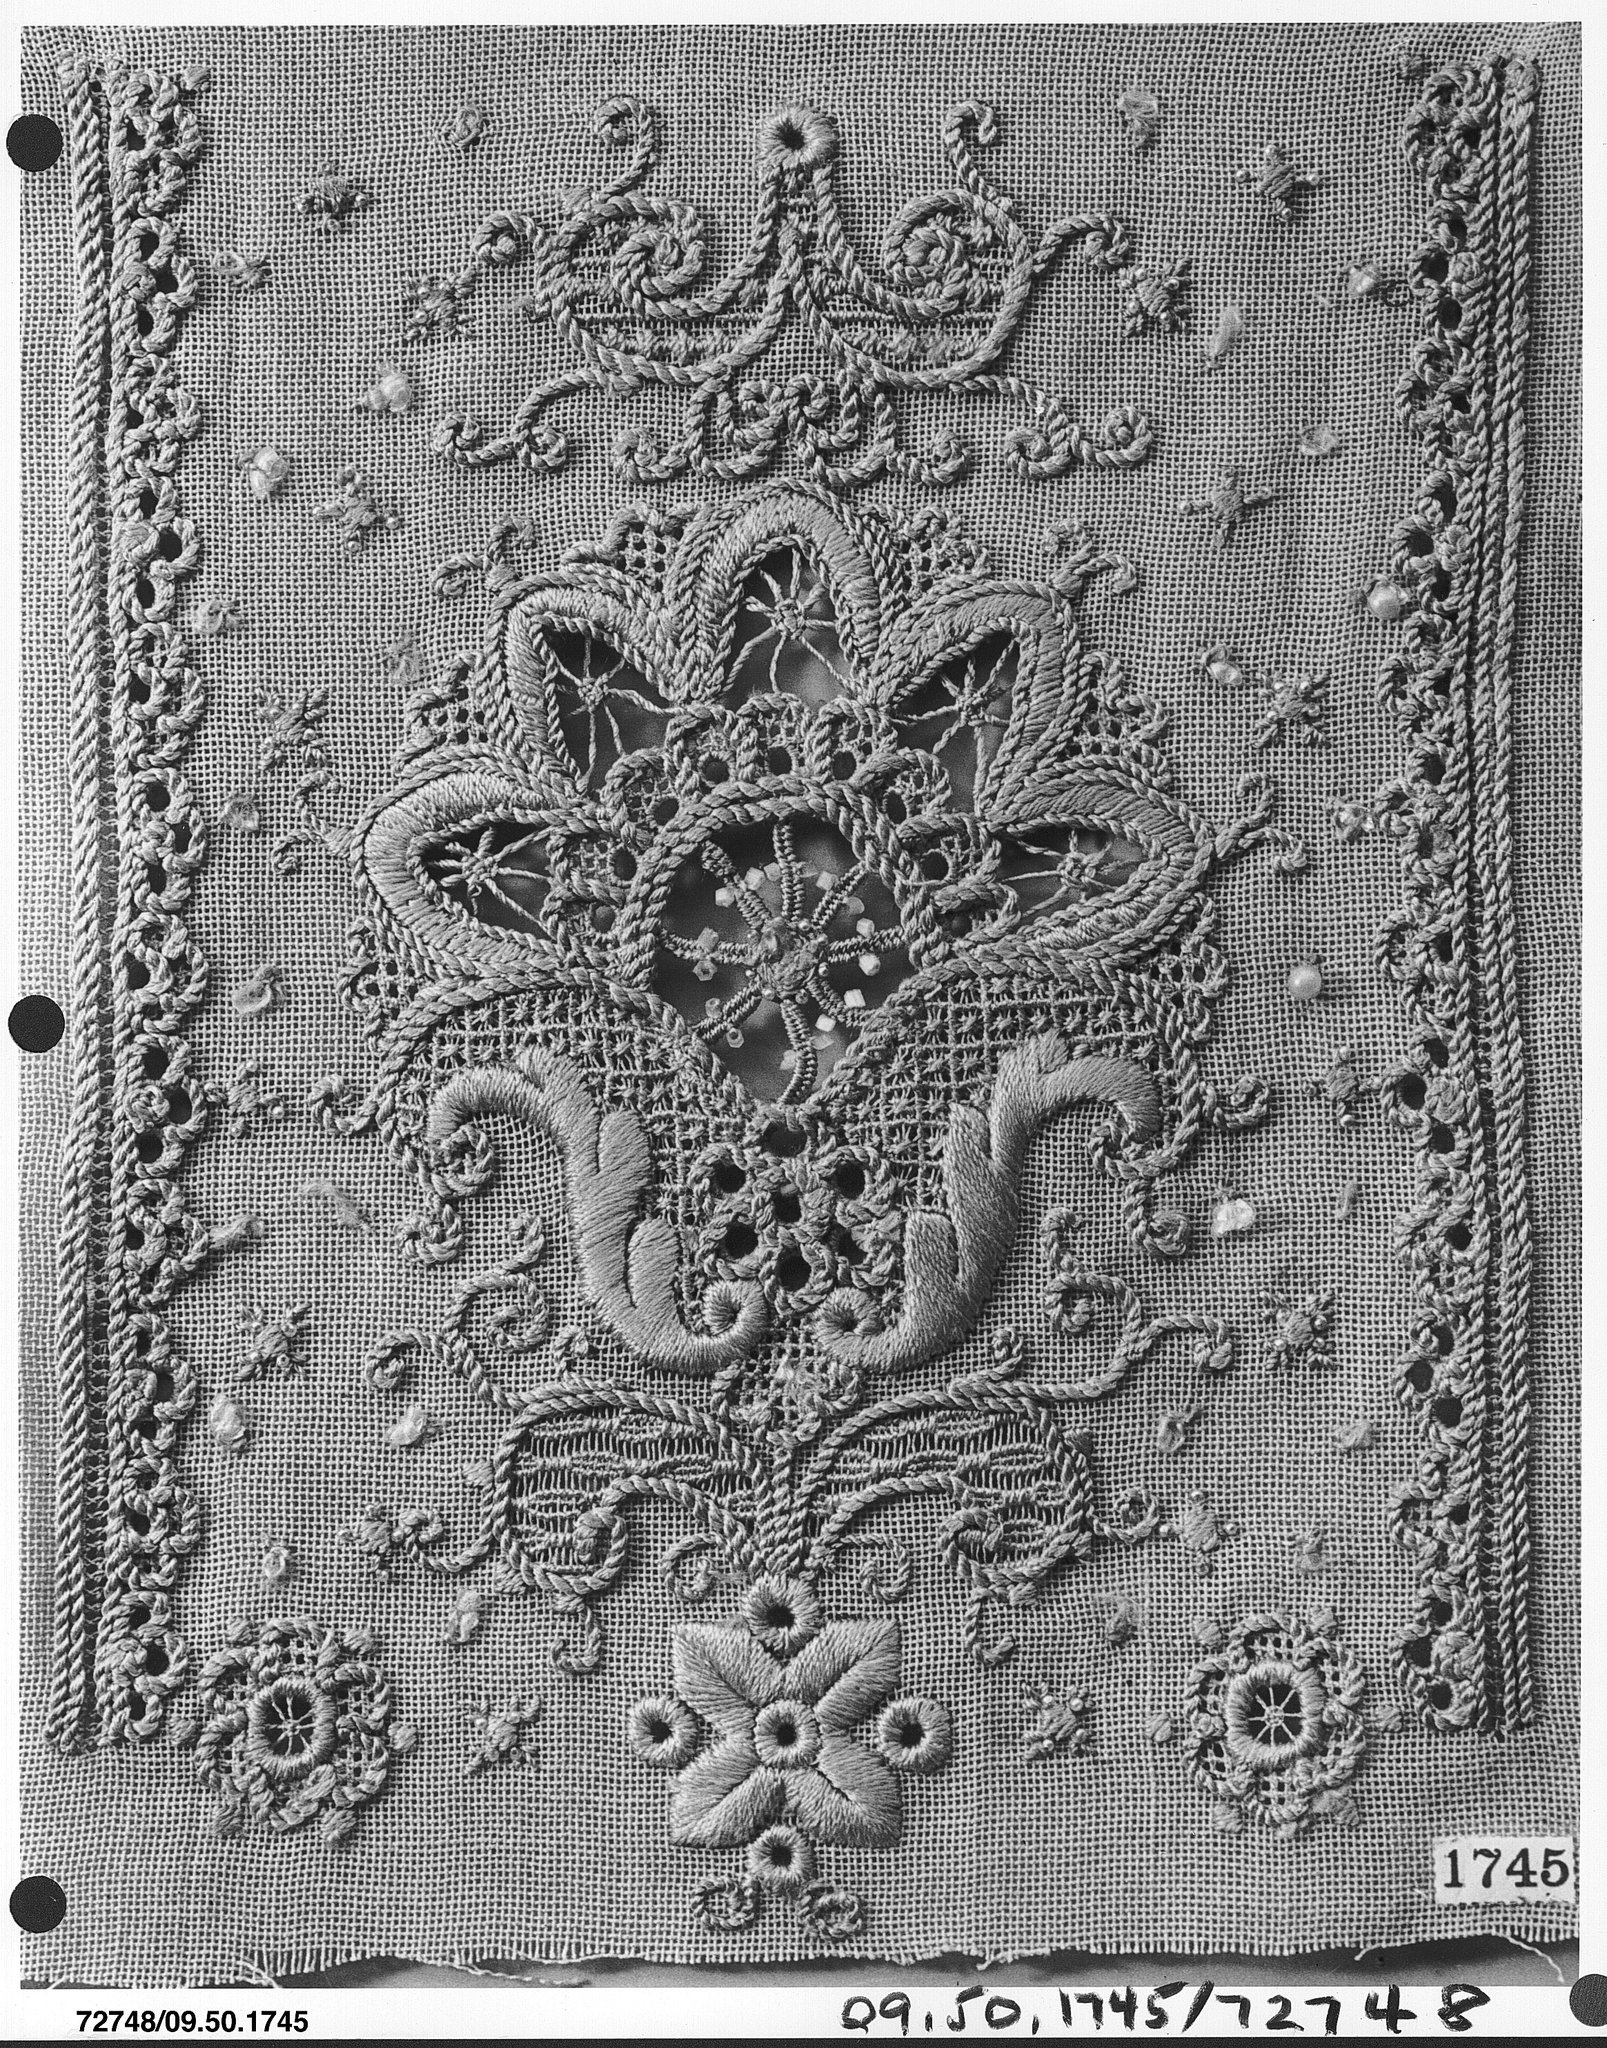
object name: fragment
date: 1801-1900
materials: canvas, silk